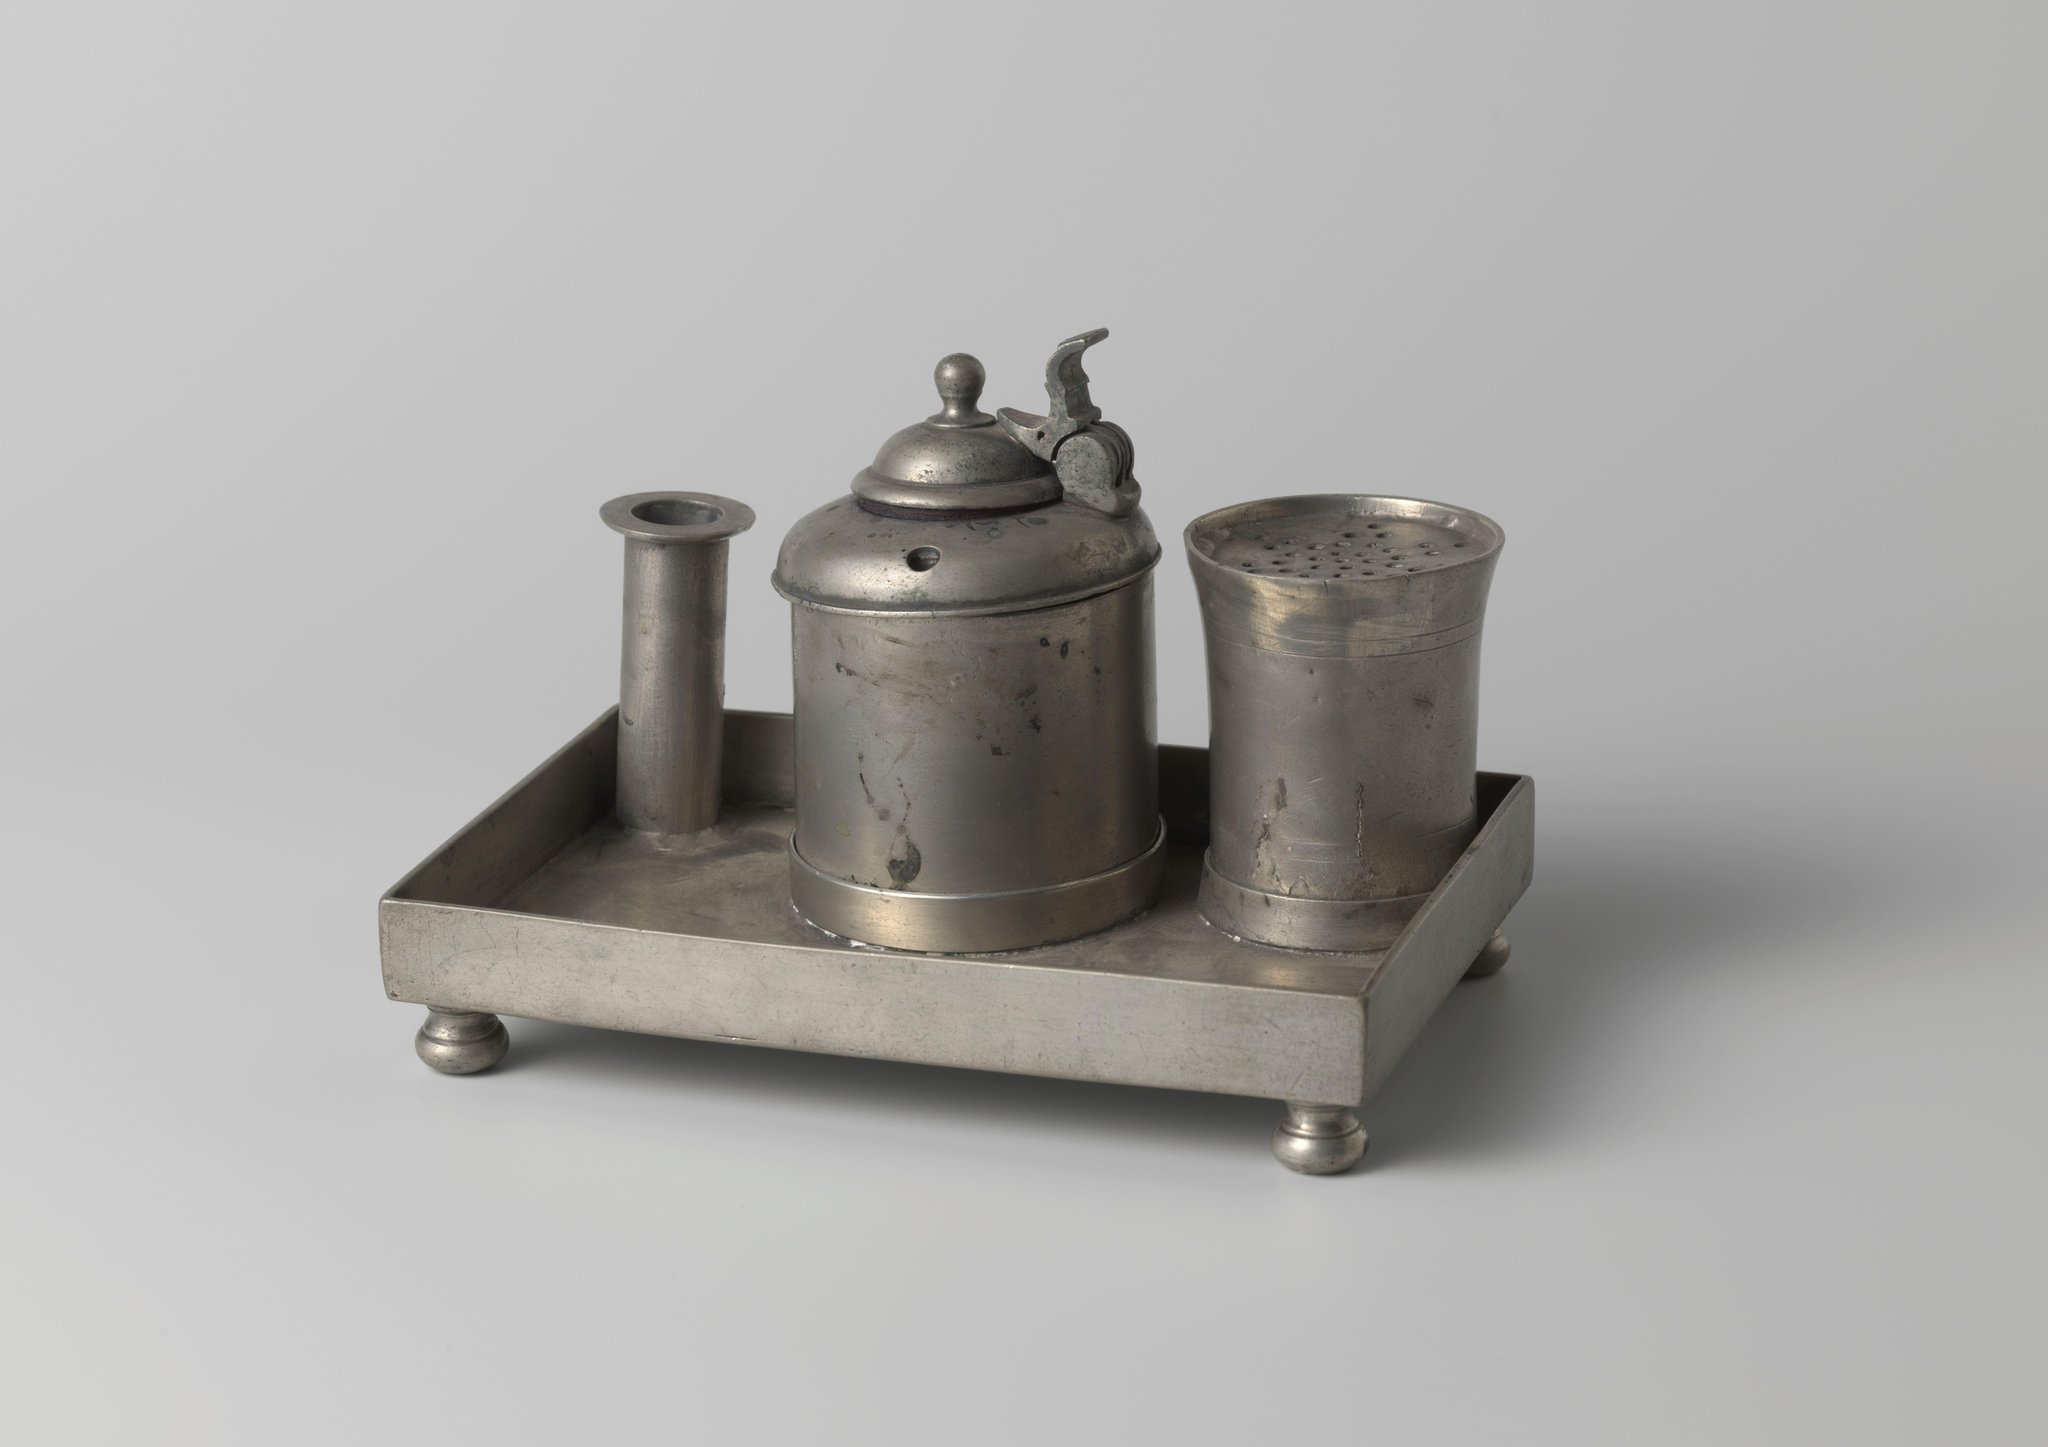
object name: onderstel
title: Onderstel van inktstel van tin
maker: Anonymous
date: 1850-1900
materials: tin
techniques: casting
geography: netherlands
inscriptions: quality mark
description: Onderstel van tin. Op vier doppen ligt een rechthoekige plaat met opstaande rand. In de bak in de linker achterhoek een hoge pennenkoker. Daarnaast bijna tegen de achterwand aan twee cirkelvormige laag, opstaande randen voor de inktpot en de zandpot.